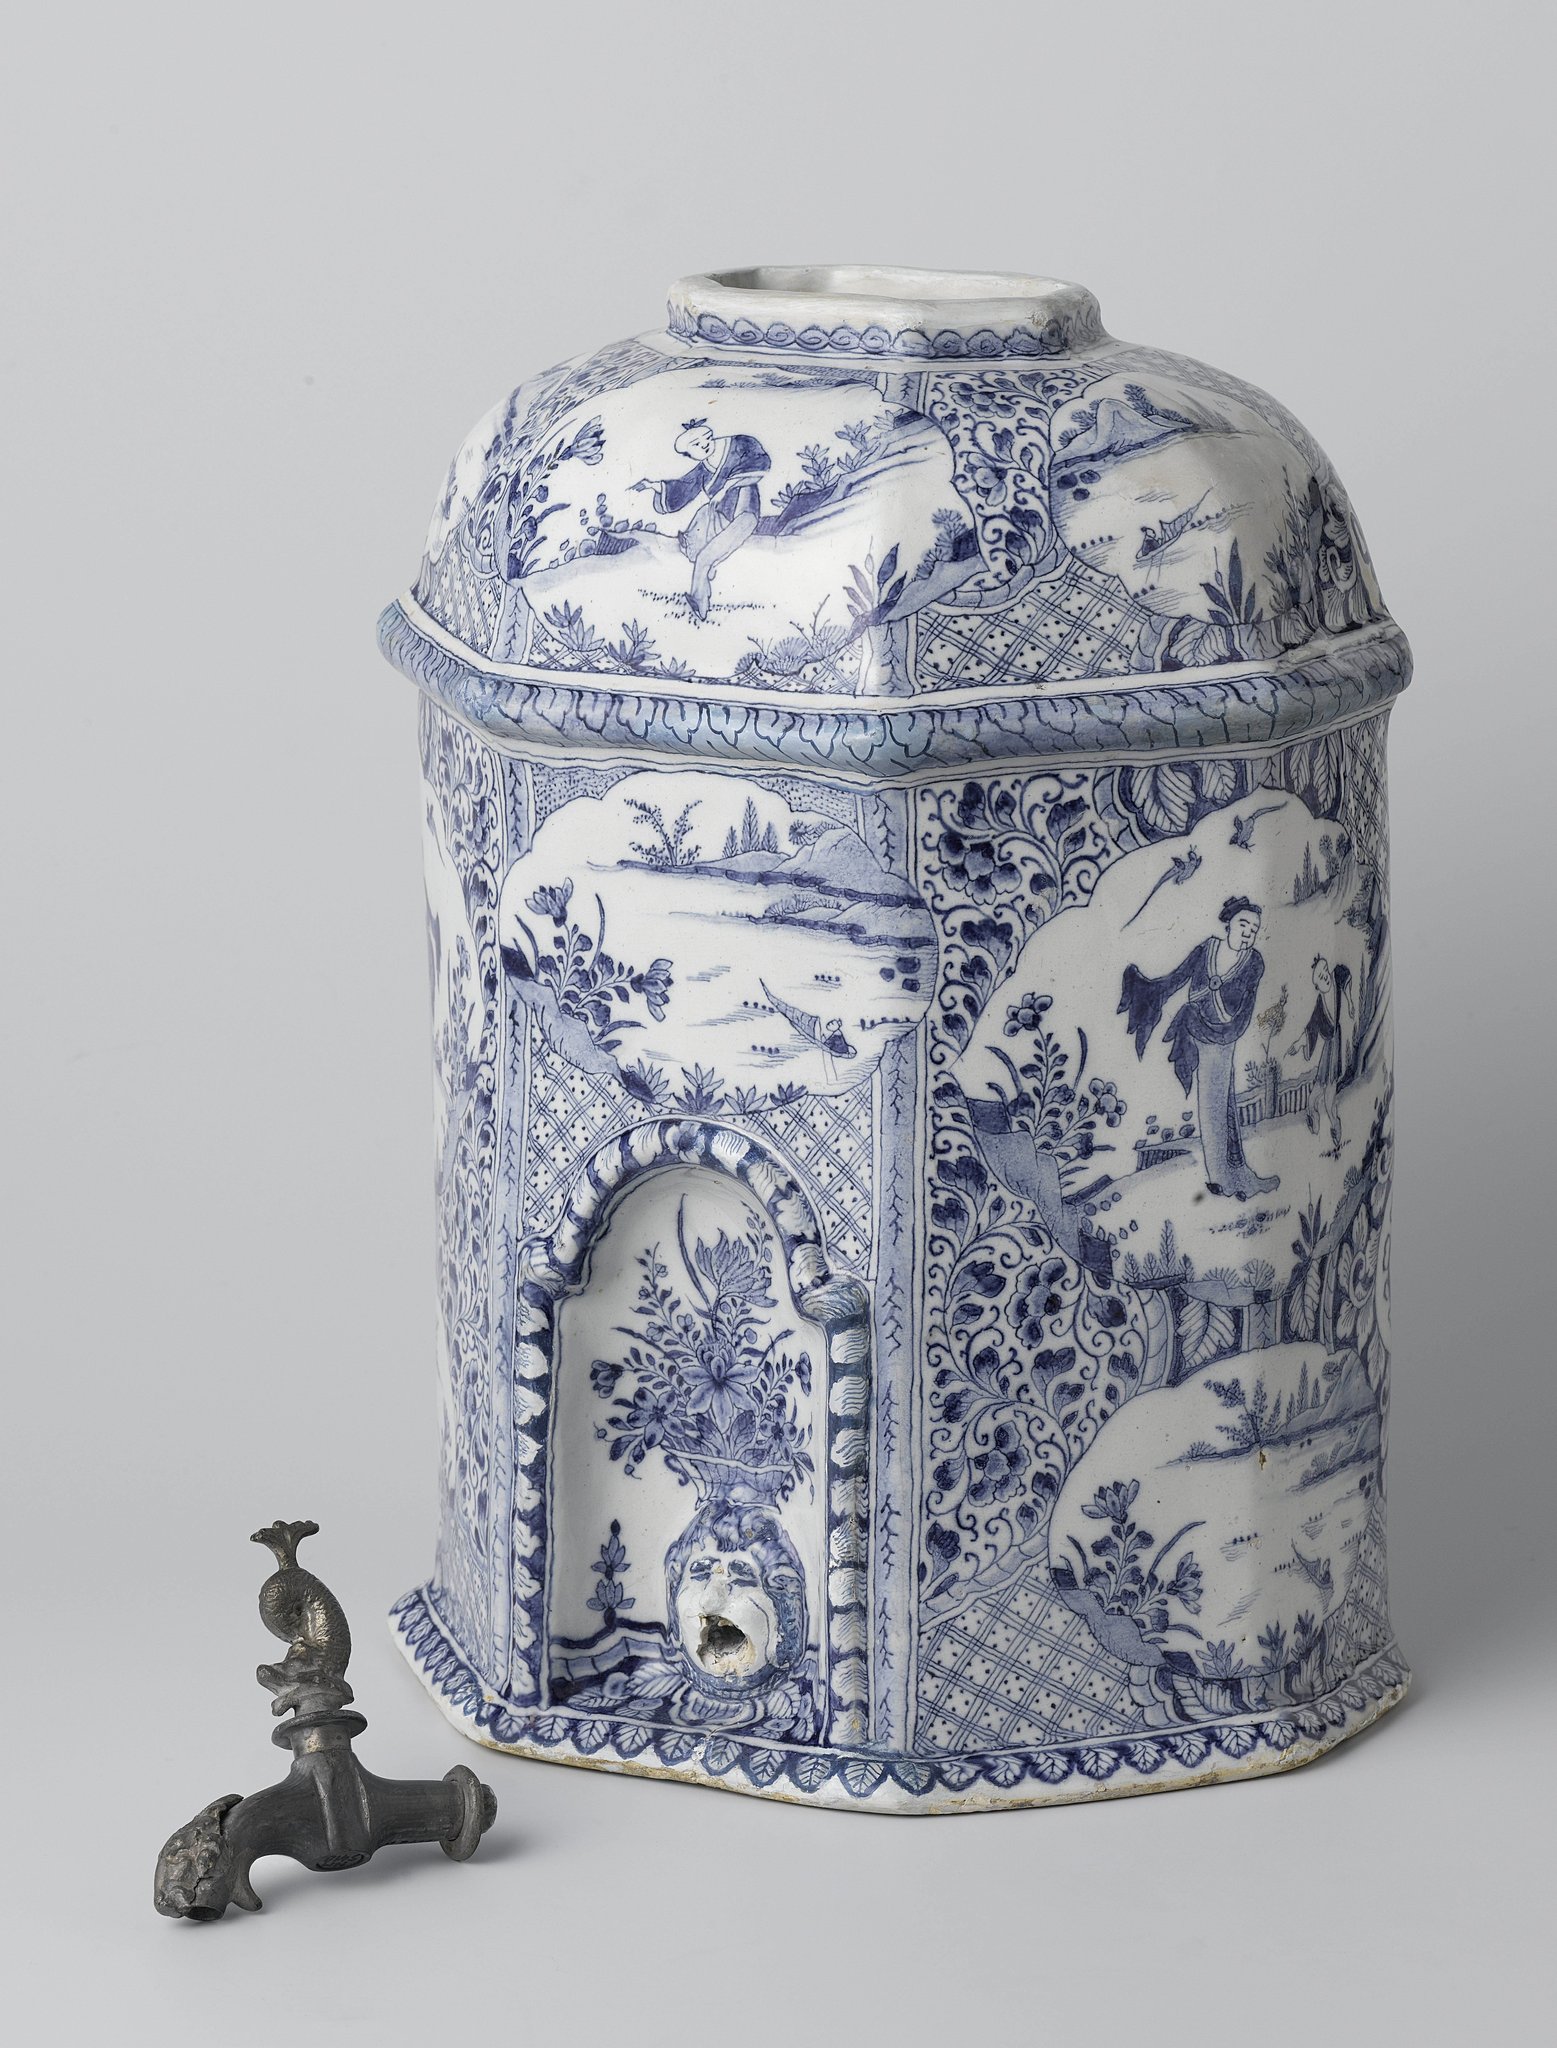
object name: fountain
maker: Anonymous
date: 1690-1730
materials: earthenware, glaze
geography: delft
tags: chinese (+ other cultural aspects), flowers ~ ornament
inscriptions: mark: ‘D/ 11’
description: Fontein van faience met chinoiserie en Lodewijk XIV decoraties.